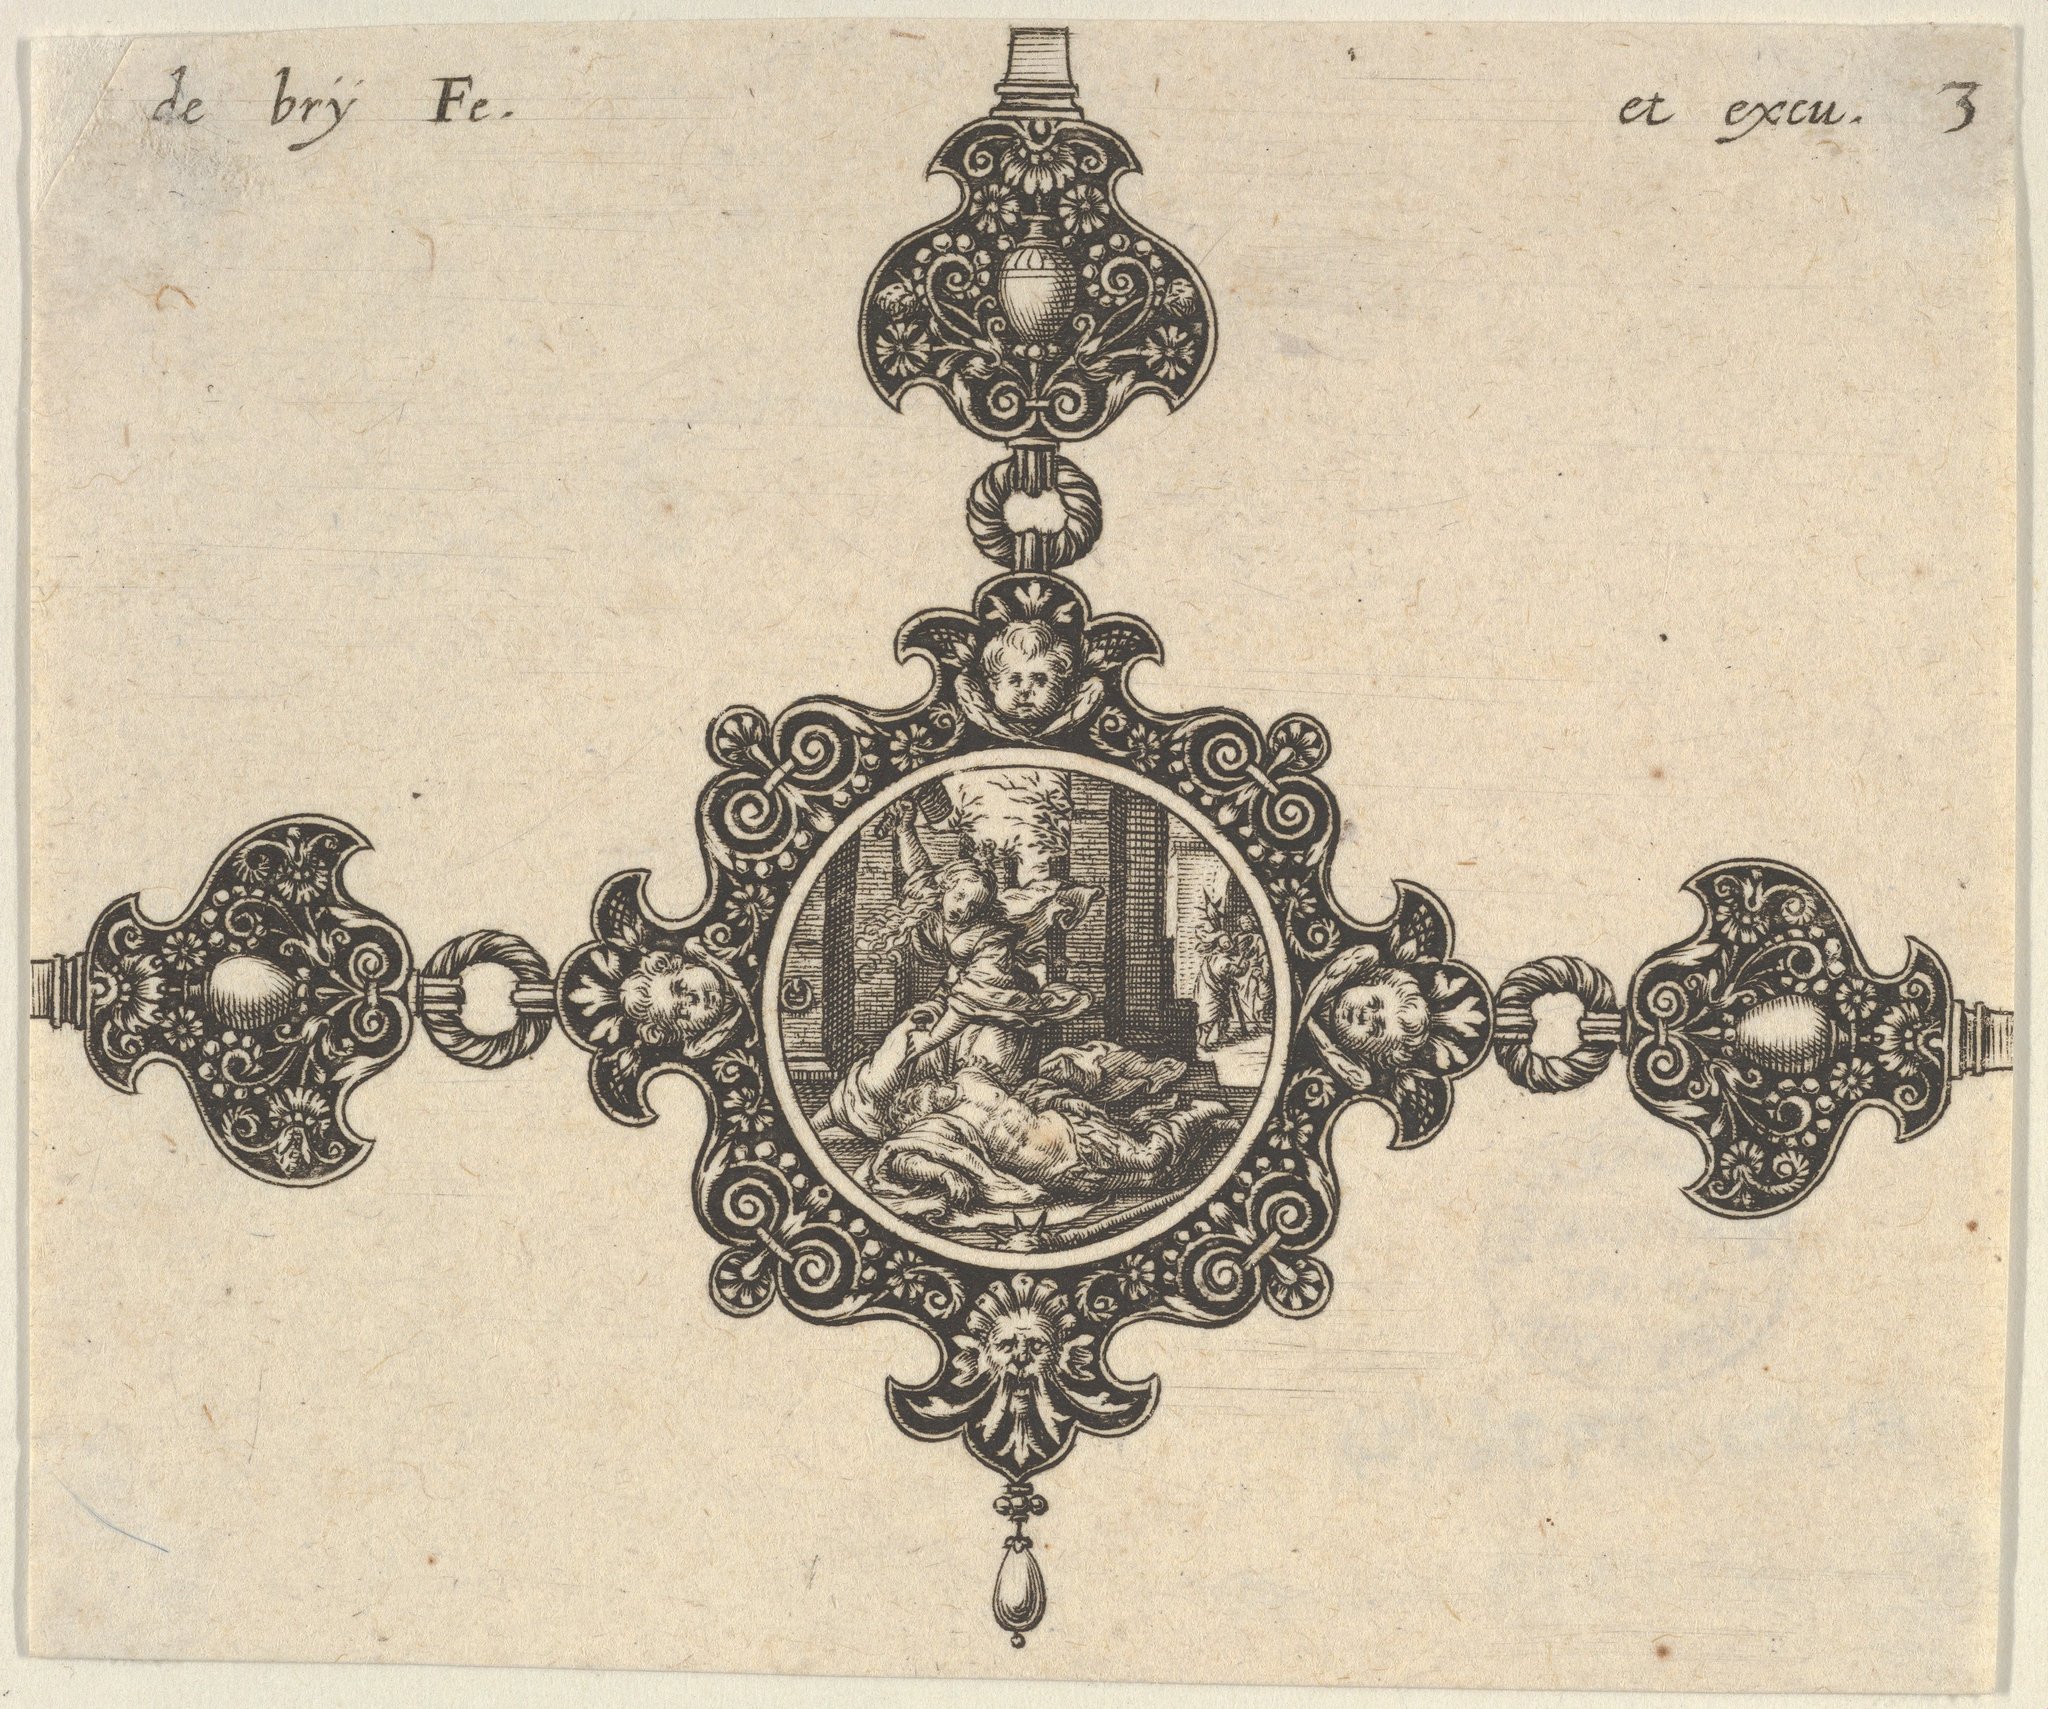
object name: print ornament architecture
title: Design for a Brooch with Jael Killing Sisera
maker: johann theodor de bry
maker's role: artist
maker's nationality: netherlandish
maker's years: 1561-1623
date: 1580-1600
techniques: embroidery, engraving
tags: jewelry,brooches